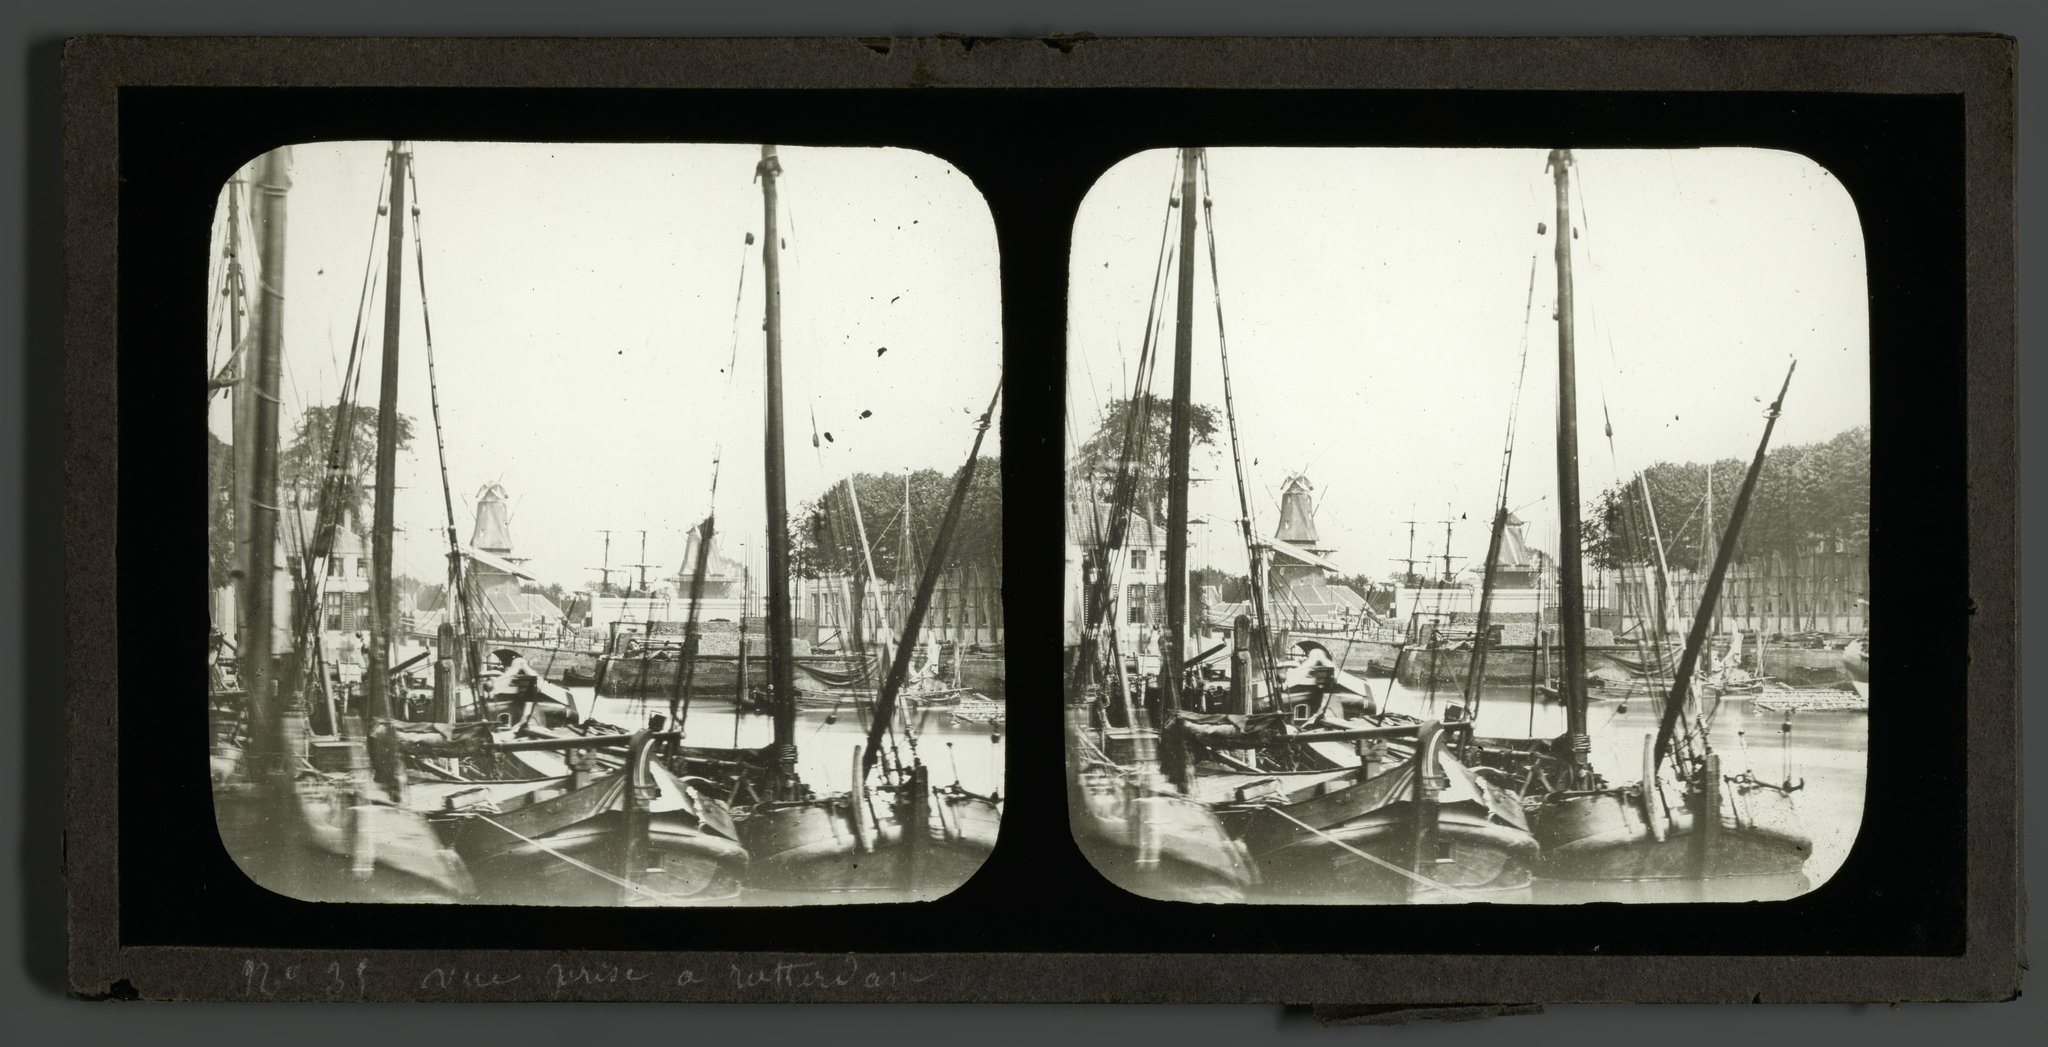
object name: photograph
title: Gezicht op de haven in Rotterdam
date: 1858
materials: glass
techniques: slide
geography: rotterdam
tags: harbour, rotterdam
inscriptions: number: ‘No. 35’